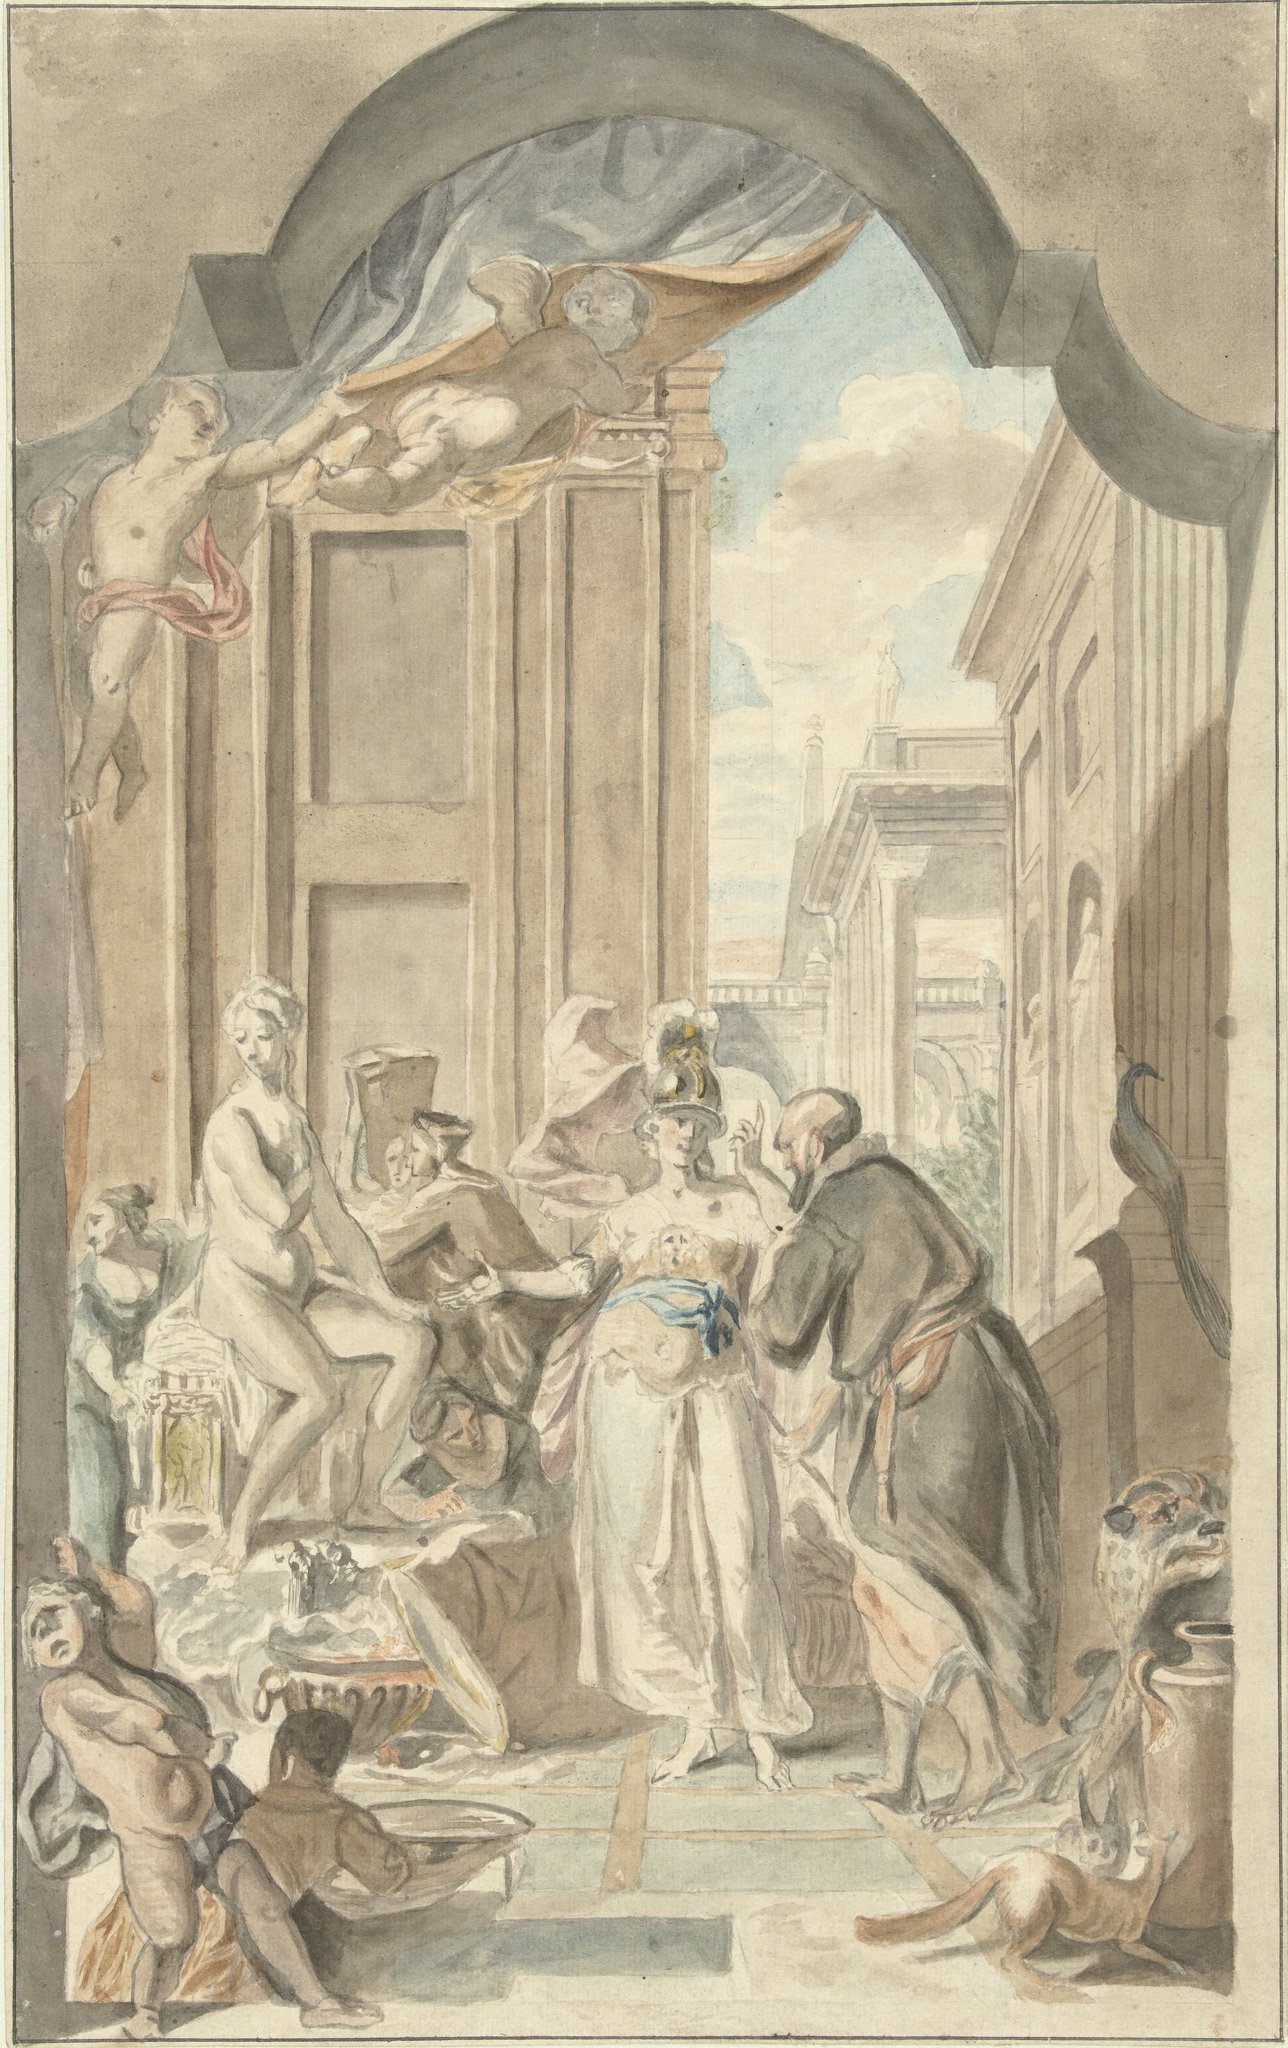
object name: drawing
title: Pallas Athene in het atelier van Prometheus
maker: jurriaan andriessen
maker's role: draughtsman, painter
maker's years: 1742-1819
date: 1752-1819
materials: ink, paper, pencil, watercolor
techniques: brush, pen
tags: prometheus makes man out of clay, usually minerva present